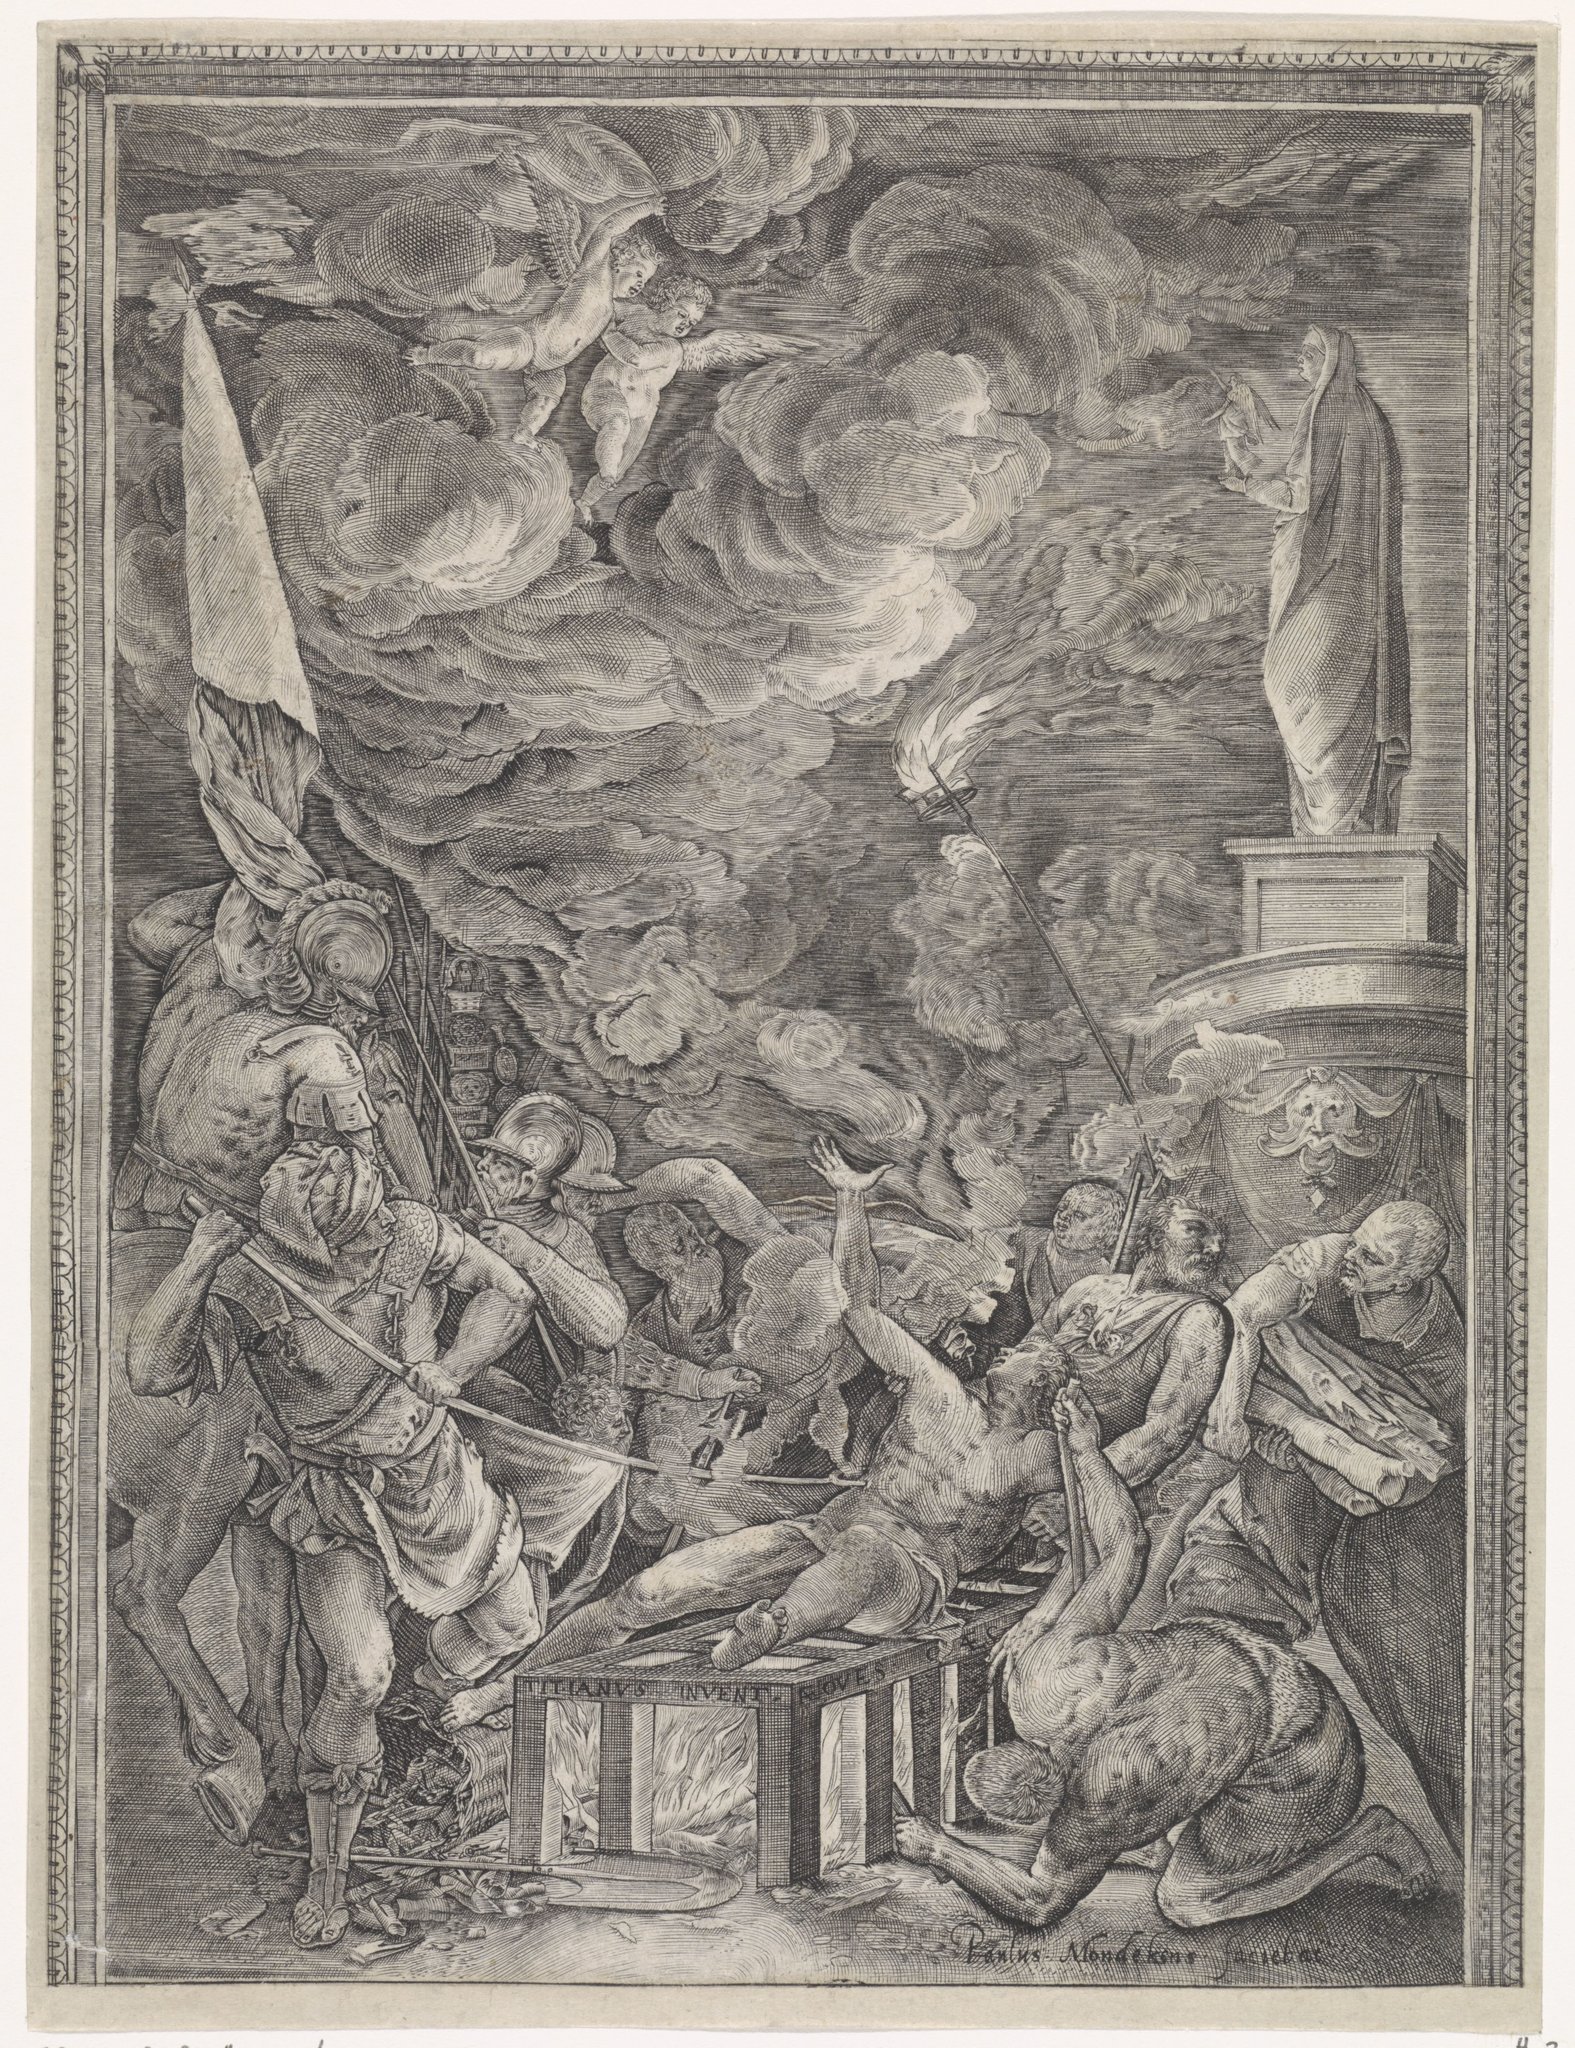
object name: print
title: Marteldood van de H. Laurentius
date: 1600-1699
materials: paper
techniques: engraving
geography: netherlands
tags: martyrdom, suffering, misfortune, death of st. laurence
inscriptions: collector's mark: Lugt 2228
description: De heilige Laurentius ligt op het rooster. Een man stookt het vuur op en een andere man brengt hout. Links een man die Laurentius met een lange pook in de zij port. Rechts op een piedestal een vrouwfiguur, mogelijk Maria, met een kleine engel of ziel in haar handen. Op de wolken twee putti.